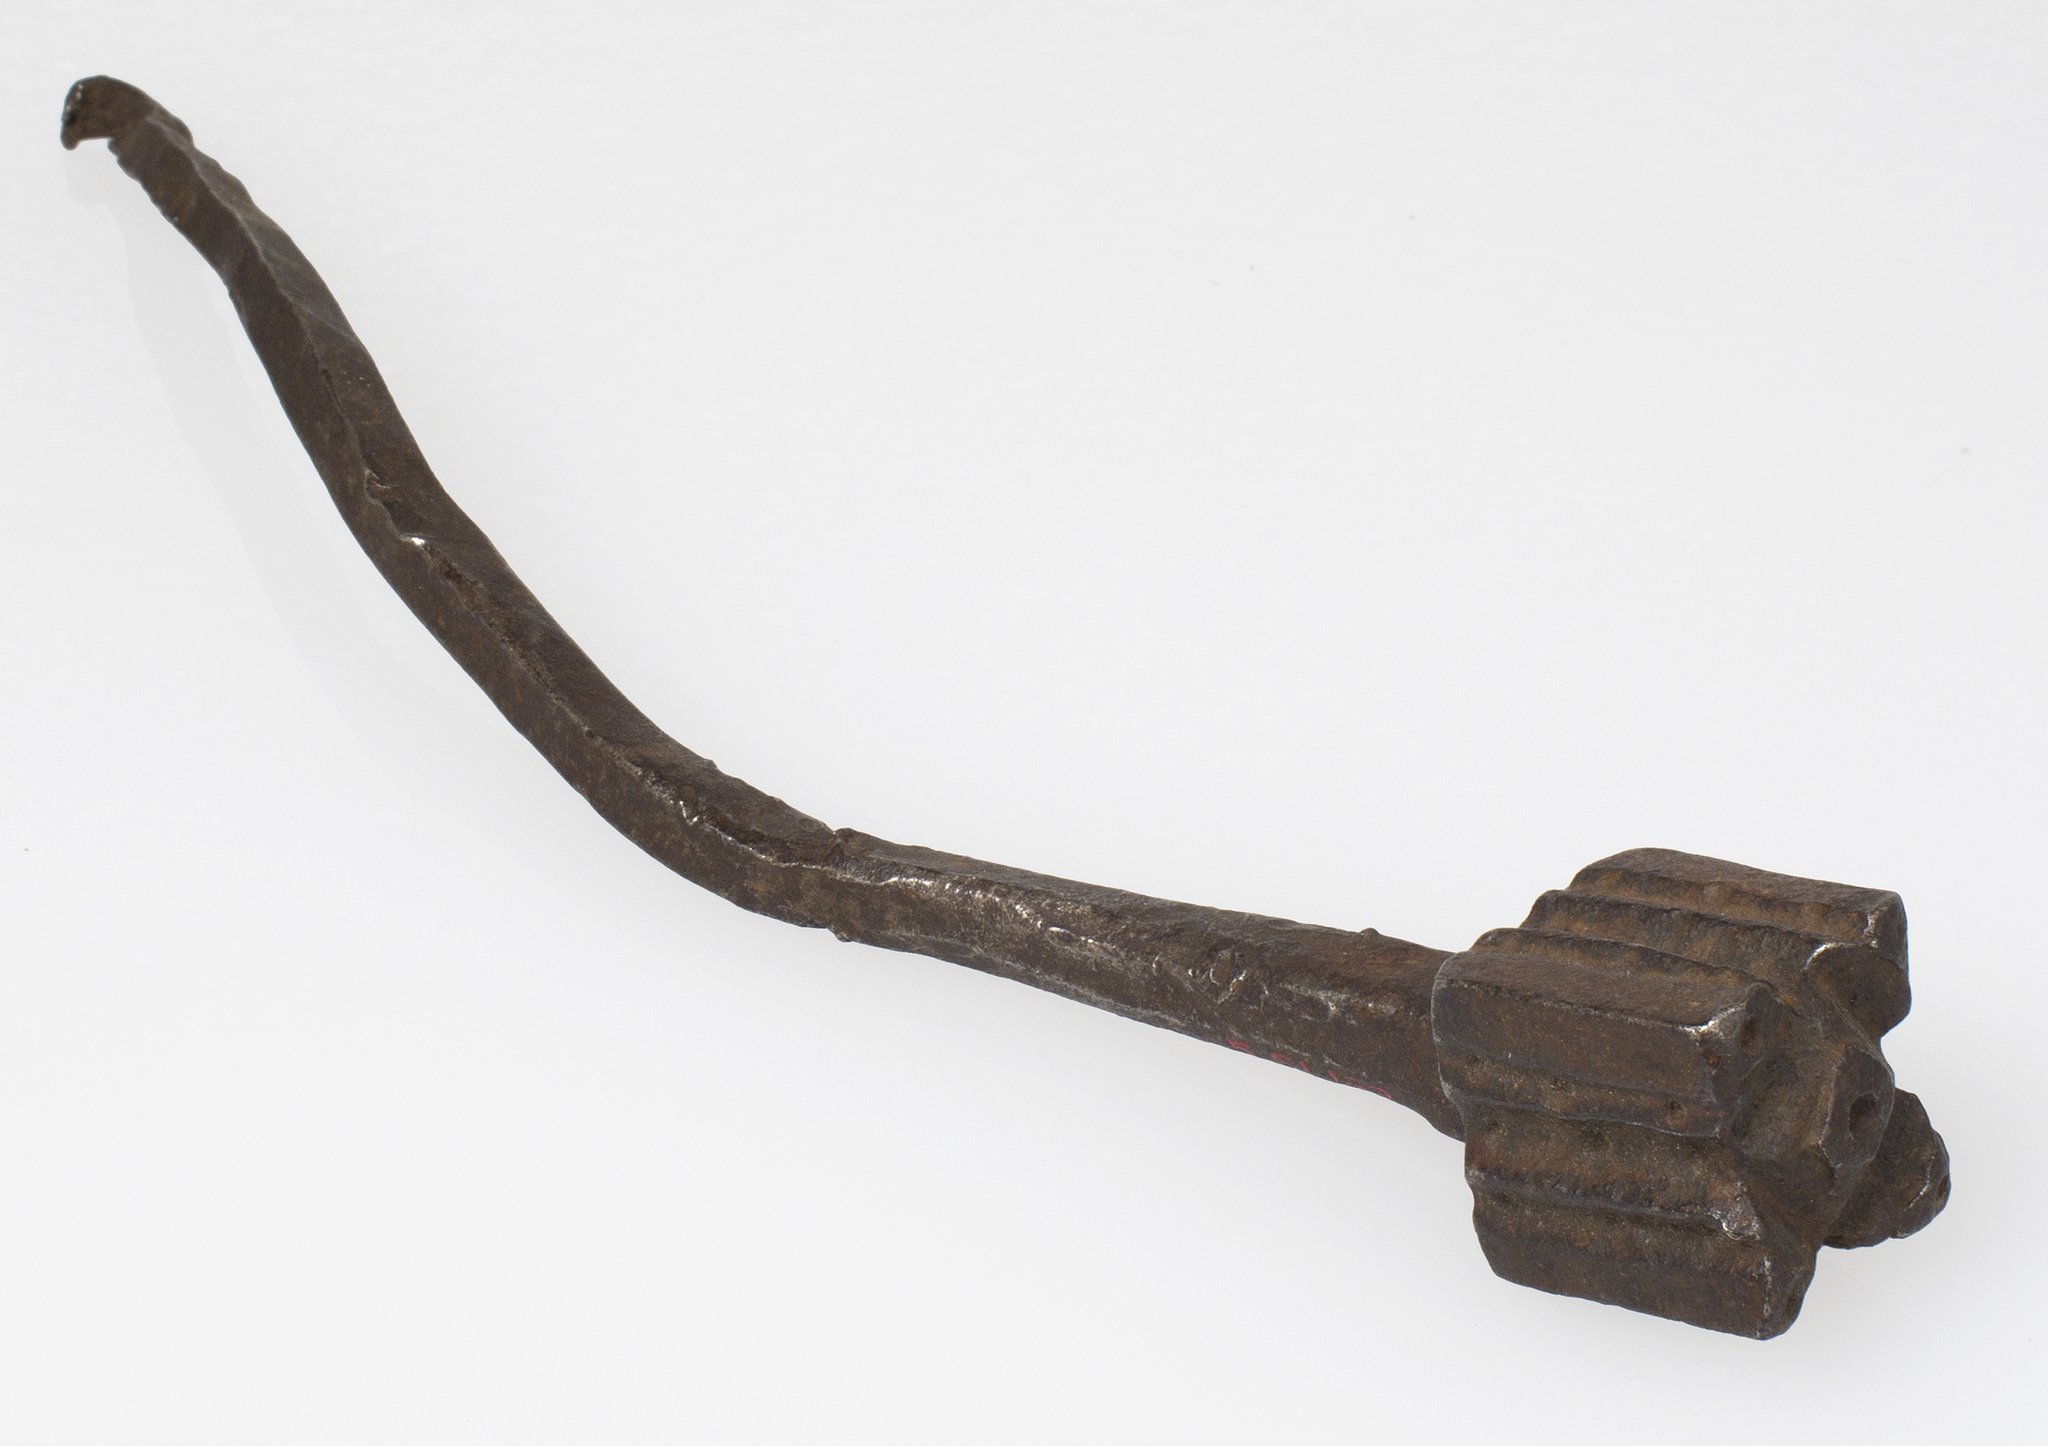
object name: nail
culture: european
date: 1401-1600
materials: iron